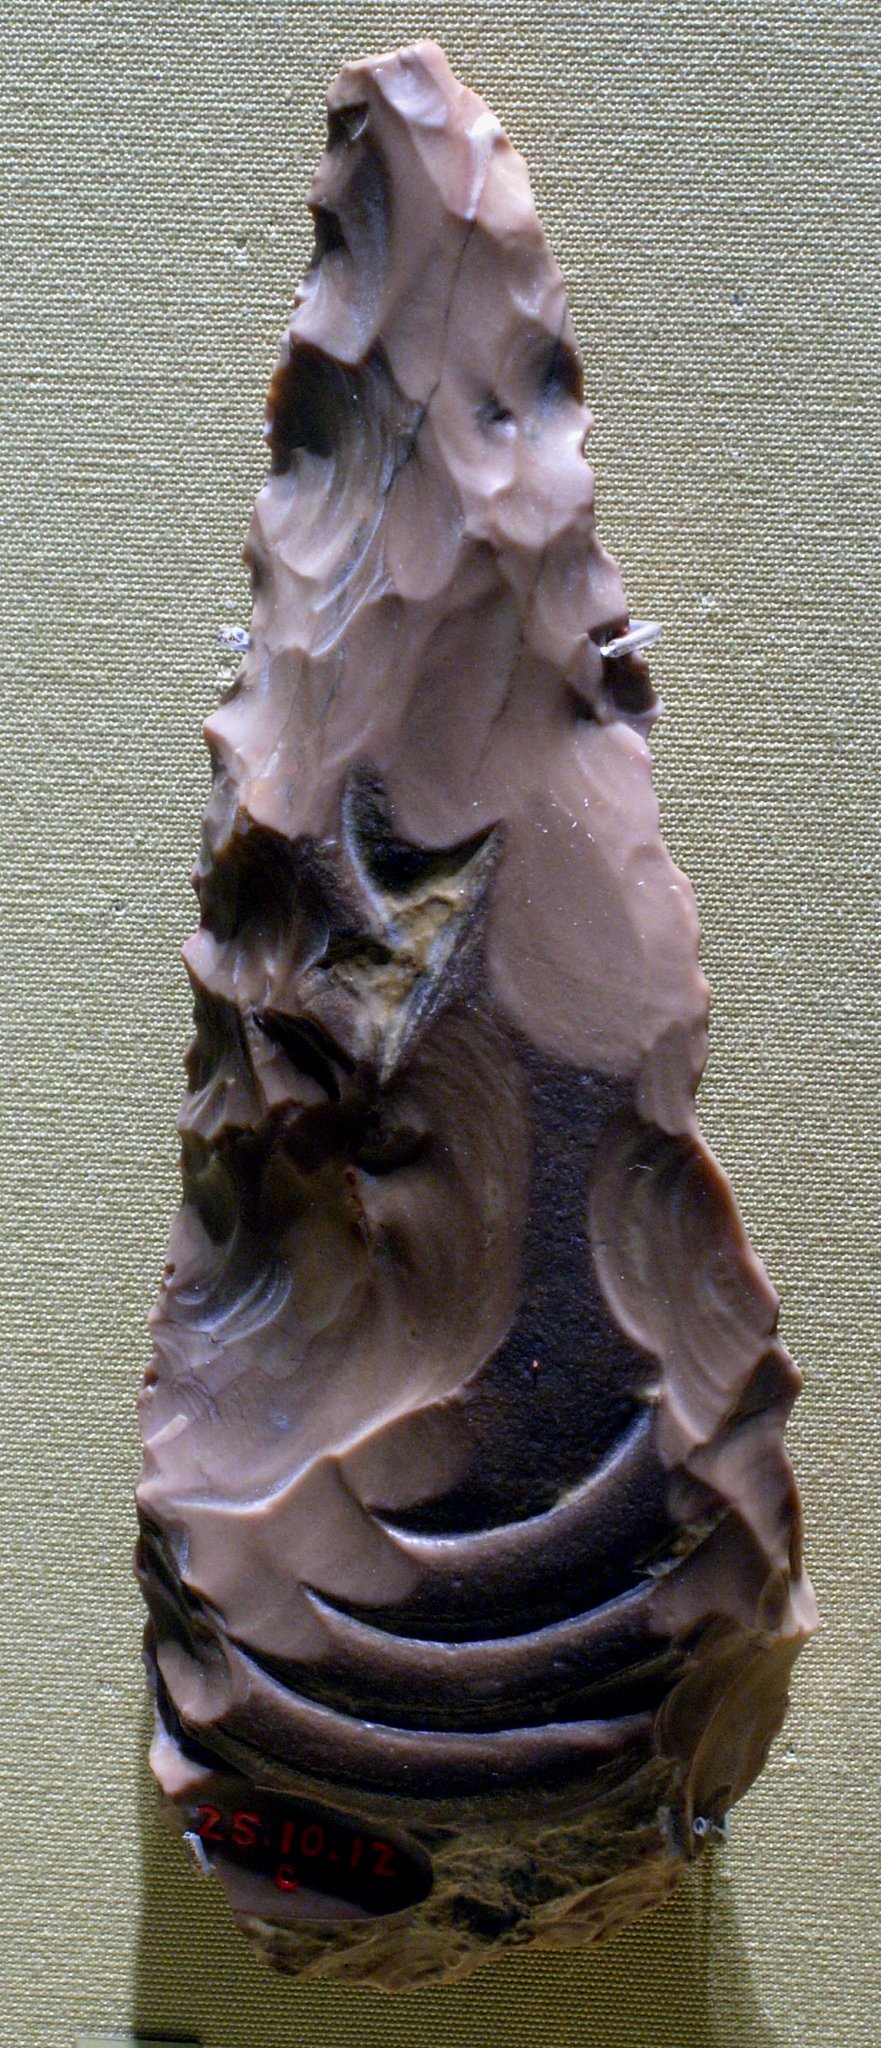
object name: tool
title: Bifacial Tool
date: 5000-3500 BCE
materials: stone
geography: egypt